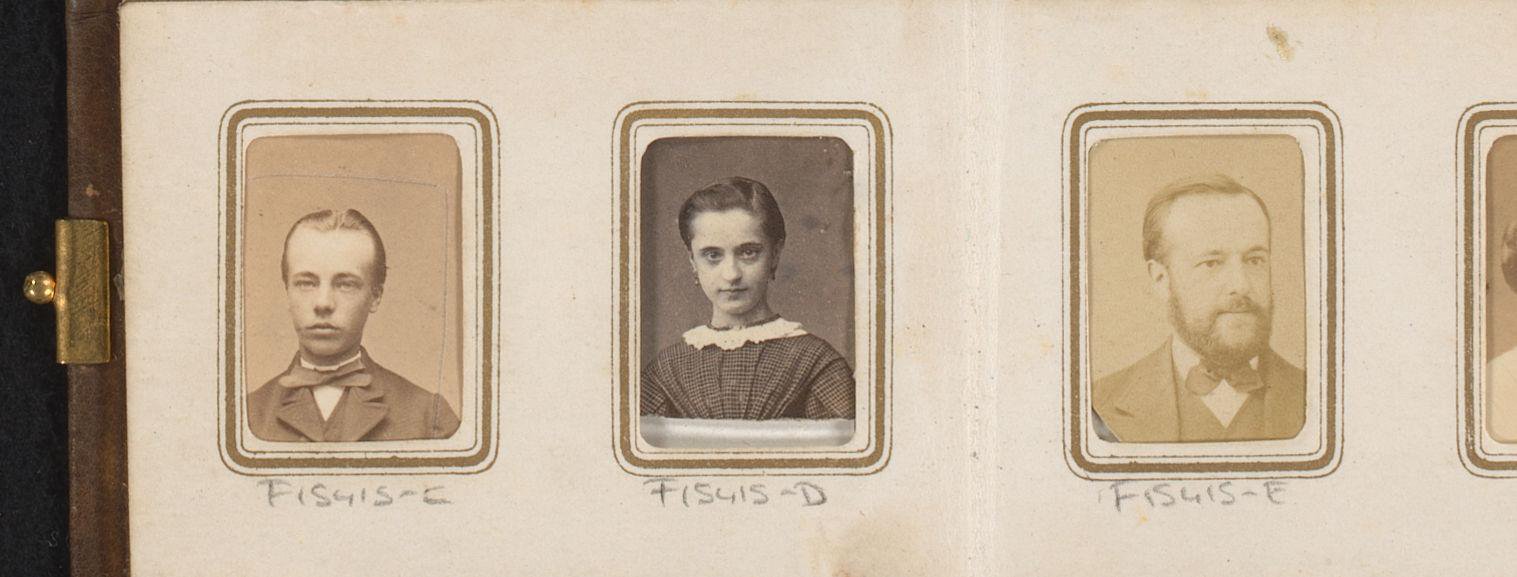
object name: album leaf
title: Miniatuurportet van een onbekend meisje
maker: Anonymous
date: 1851-1870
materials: paper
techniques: albumen print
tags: girl (child between toddler and youth), anonymous historical person portrayed